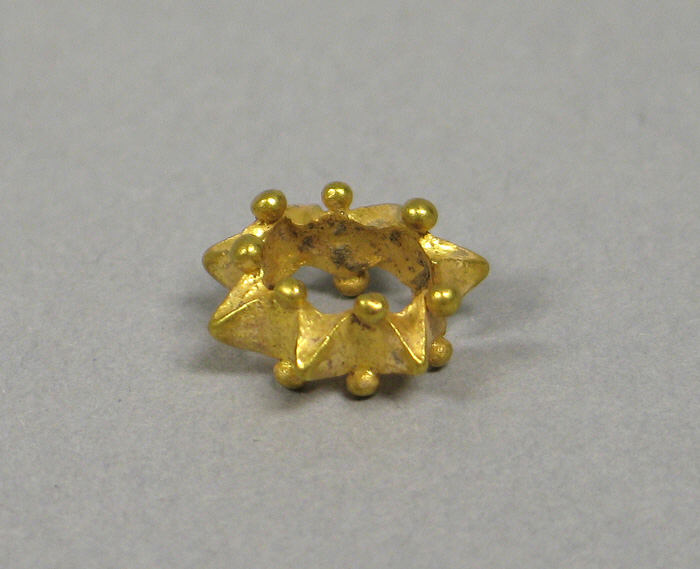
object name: pair of ear ornament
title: Pair of Ear Ornaments in Star Form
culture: indonesian, central java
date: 701-1200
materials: gold